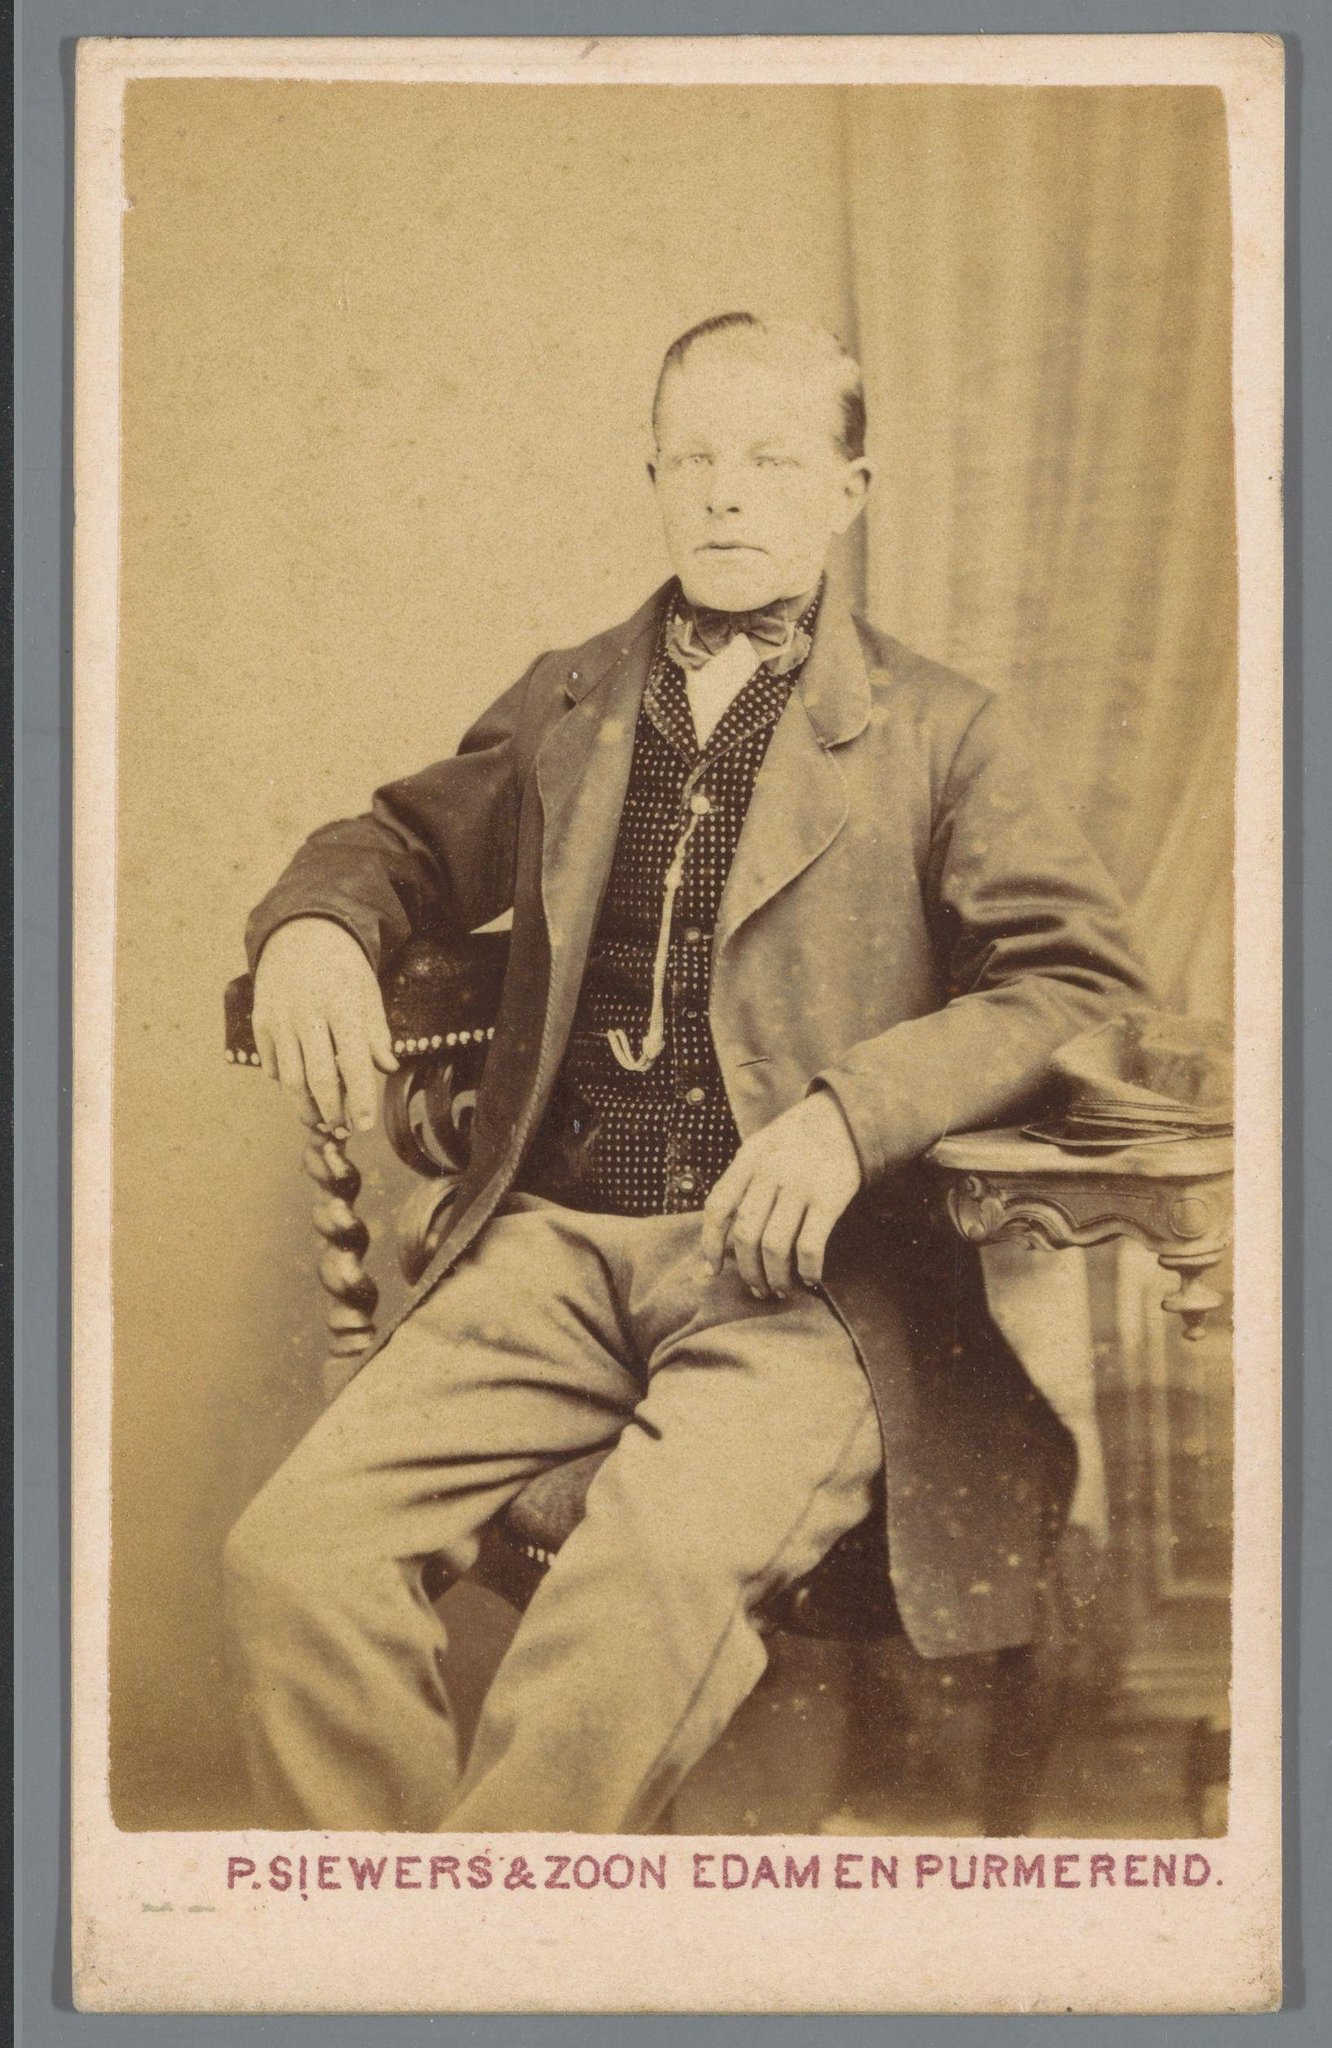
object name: carte de visite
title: Portret van een onbekende jonge man aan een tafel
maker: pieter siewers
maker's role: fotograaf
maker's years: 1819-1898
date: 1857-1885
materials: cardboard, paper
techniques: albumen print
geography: edam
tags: youth, adolescent, anonymous historical person portrayed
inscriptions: inscription: ‘Te Edam dagelijks werkzaam/ Te Purmerend, zondag & dinsdag/ de negatieven blijven bewaard tot nabestelling.’, address: ‘Edam/ en/ Purmerend’